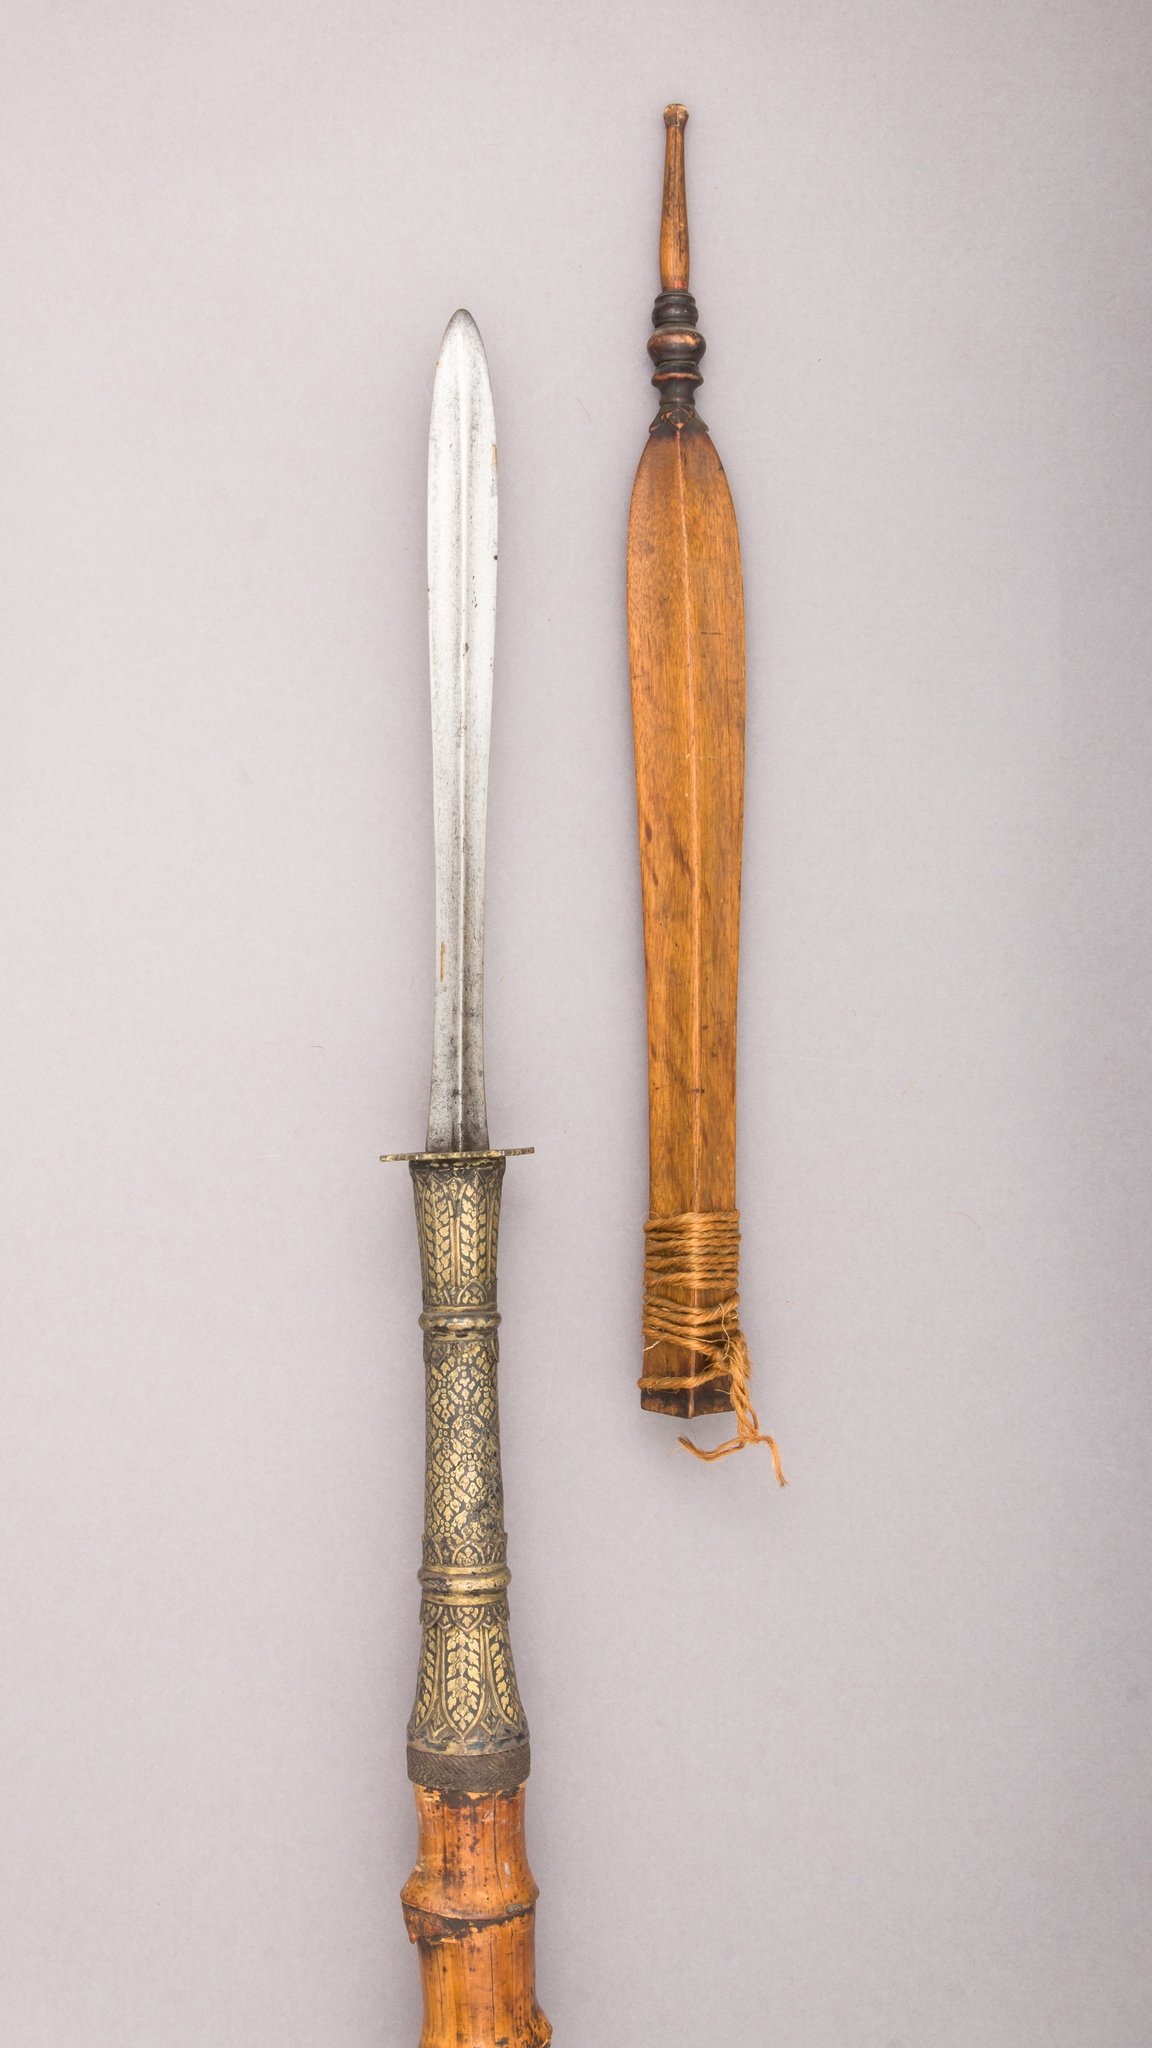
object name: lance with sheath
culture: thai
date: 1701-1900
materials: bamboo, gold, wood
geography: thailand